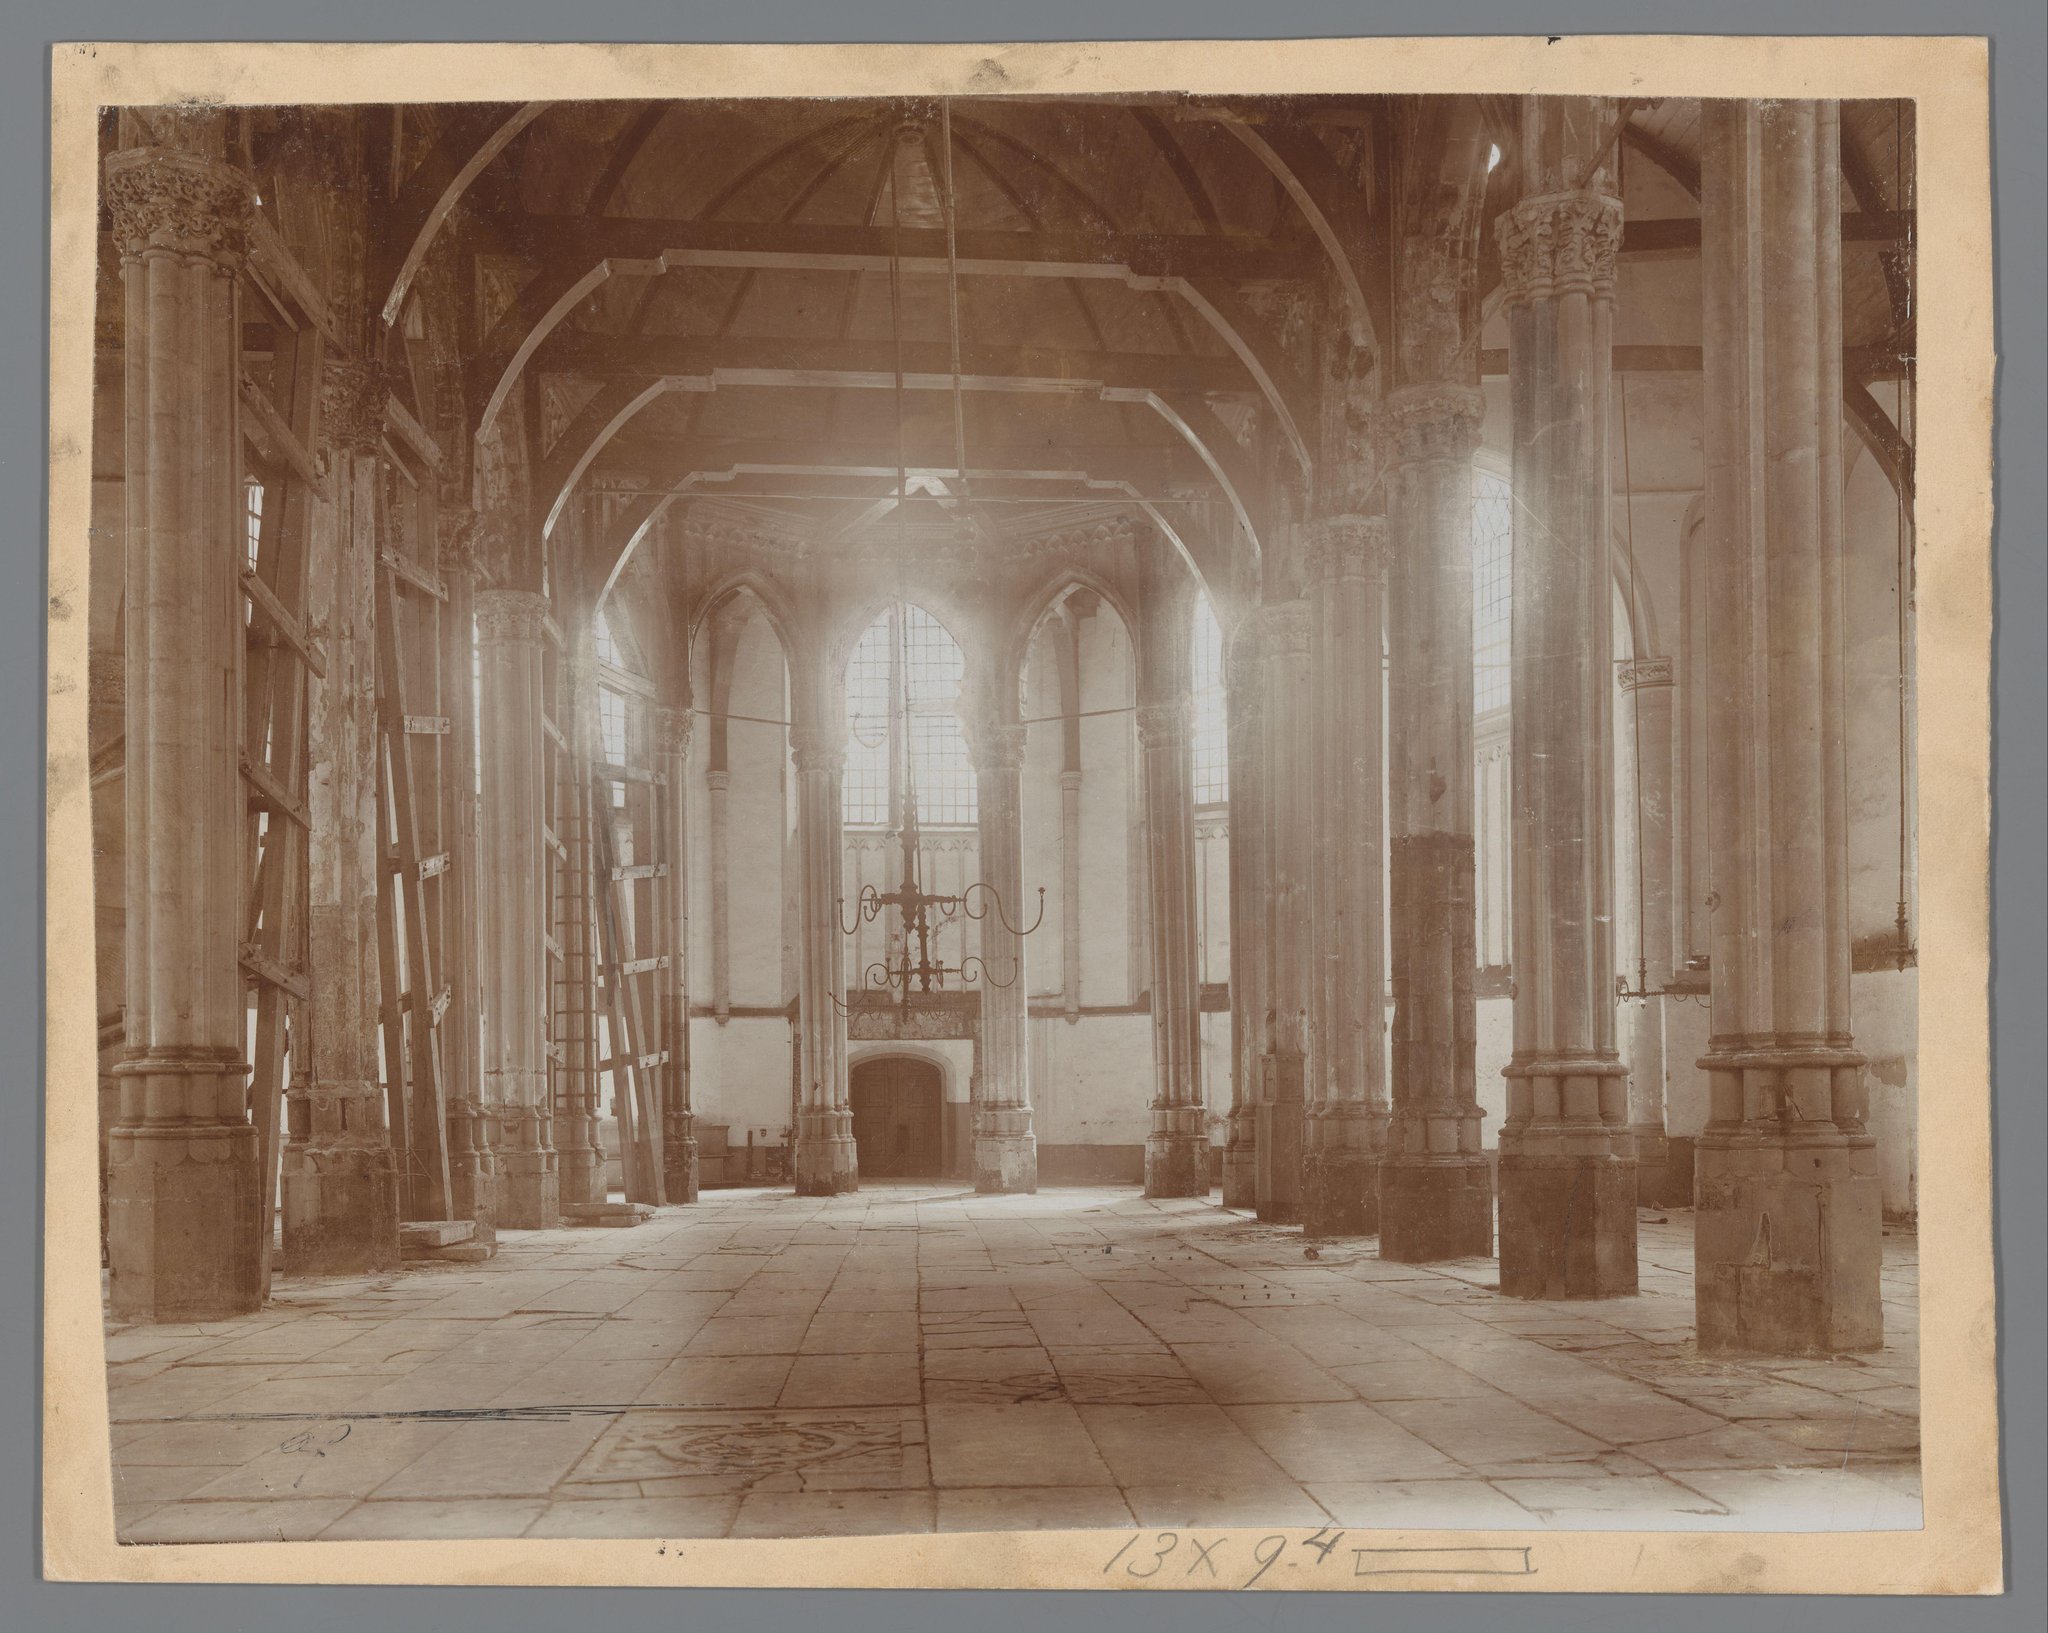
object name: photograph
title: Interieur van de Nieuwezijds Kapel te Amsterdam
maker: albert adriaansz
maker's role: fotograaf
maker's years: 1877-1941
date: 1908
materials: cardboard, photographic support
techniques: collodion silver print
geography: amsterdam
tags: interior of church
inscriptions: collector's mark: Lugt 2228, annotation: ‘2135XZ/ Tijd/ v. Kalverstraat naar Rokin/ voor altaar/ 13cm breed/ 08.128’, annotation: ‘13x9,4’